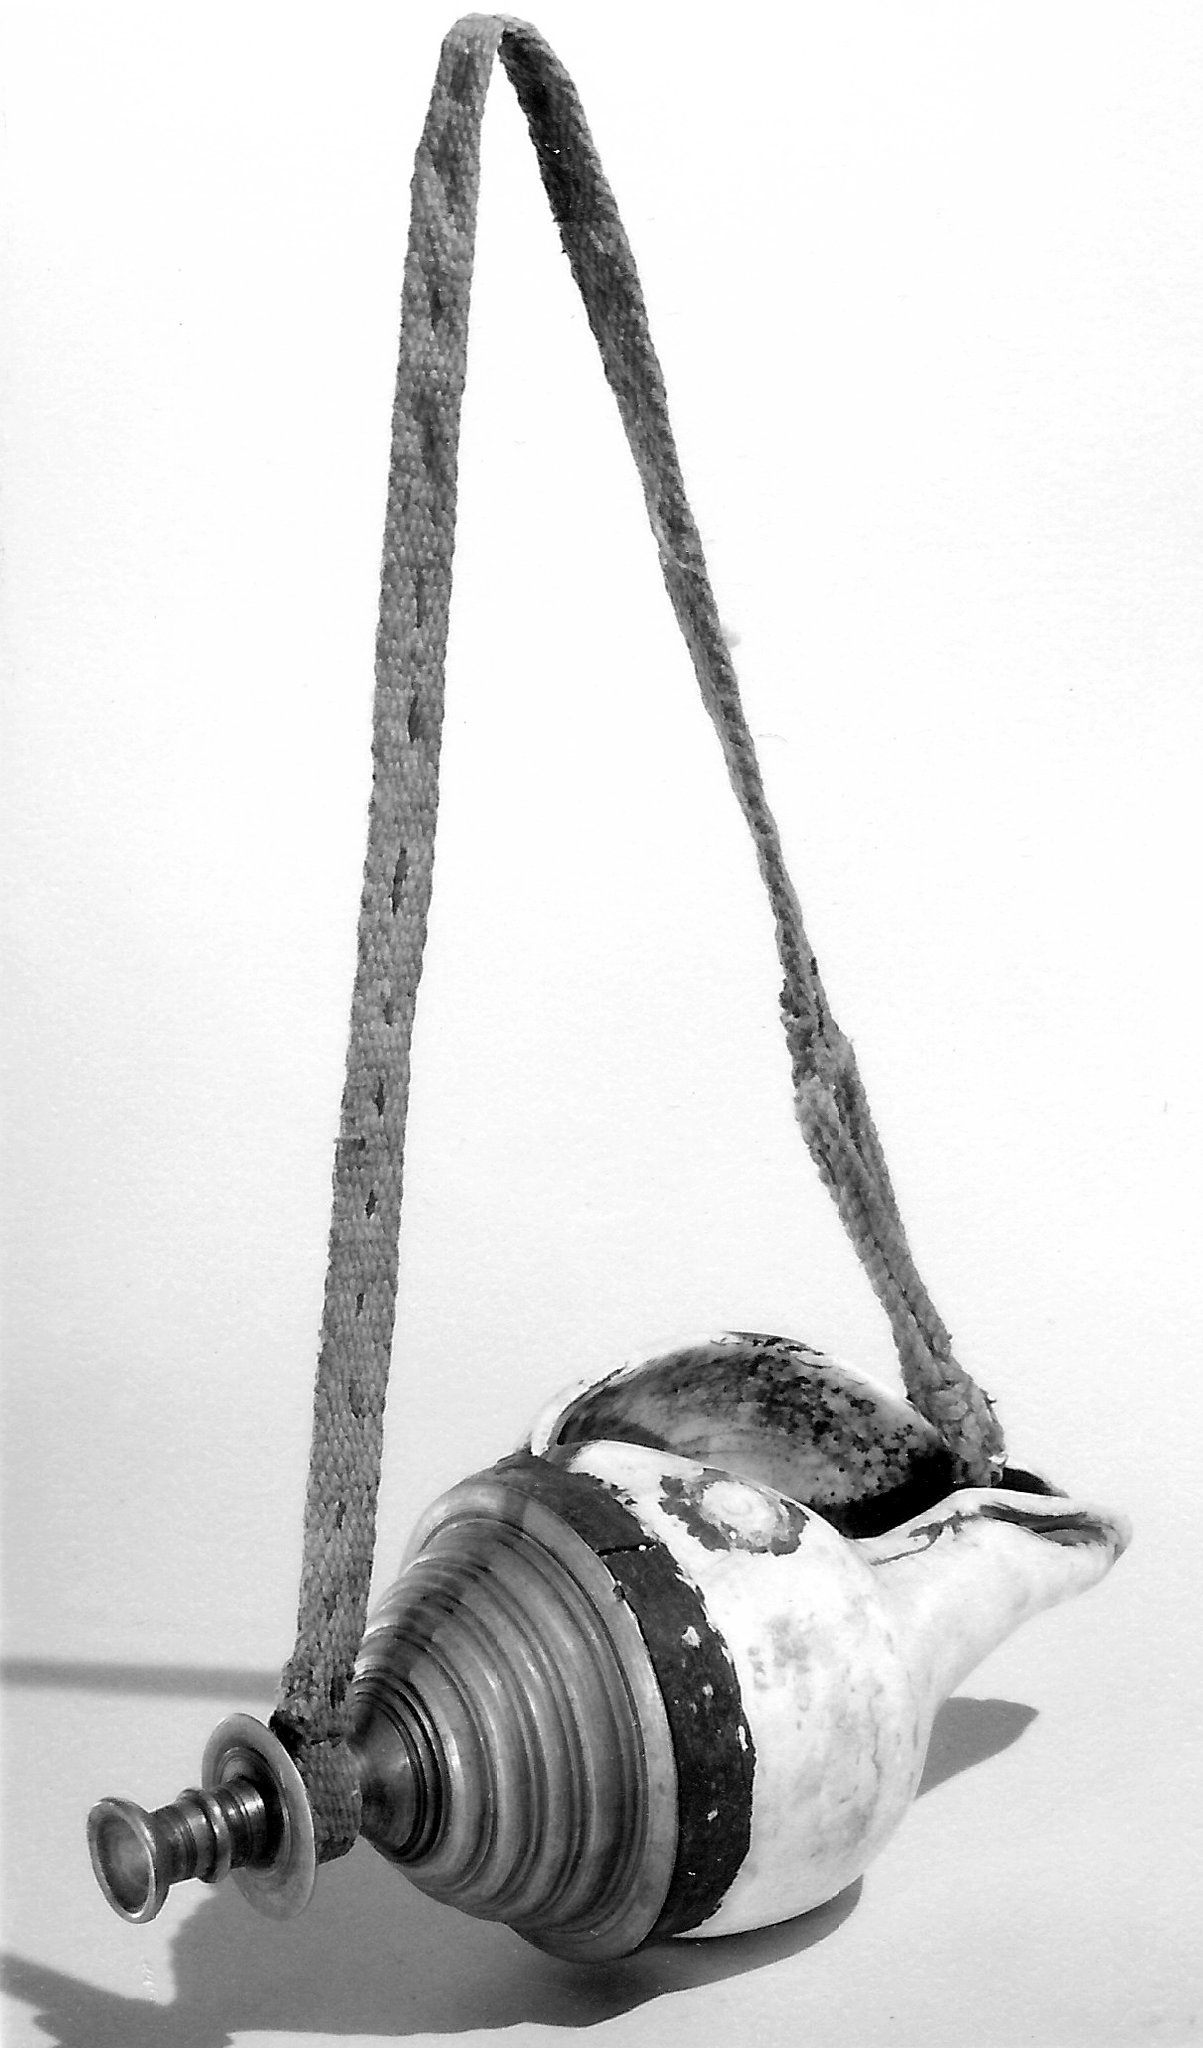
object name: sankh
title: Śaṅkh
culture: indian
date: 1867-1933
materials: metal, shell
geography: india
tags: shells